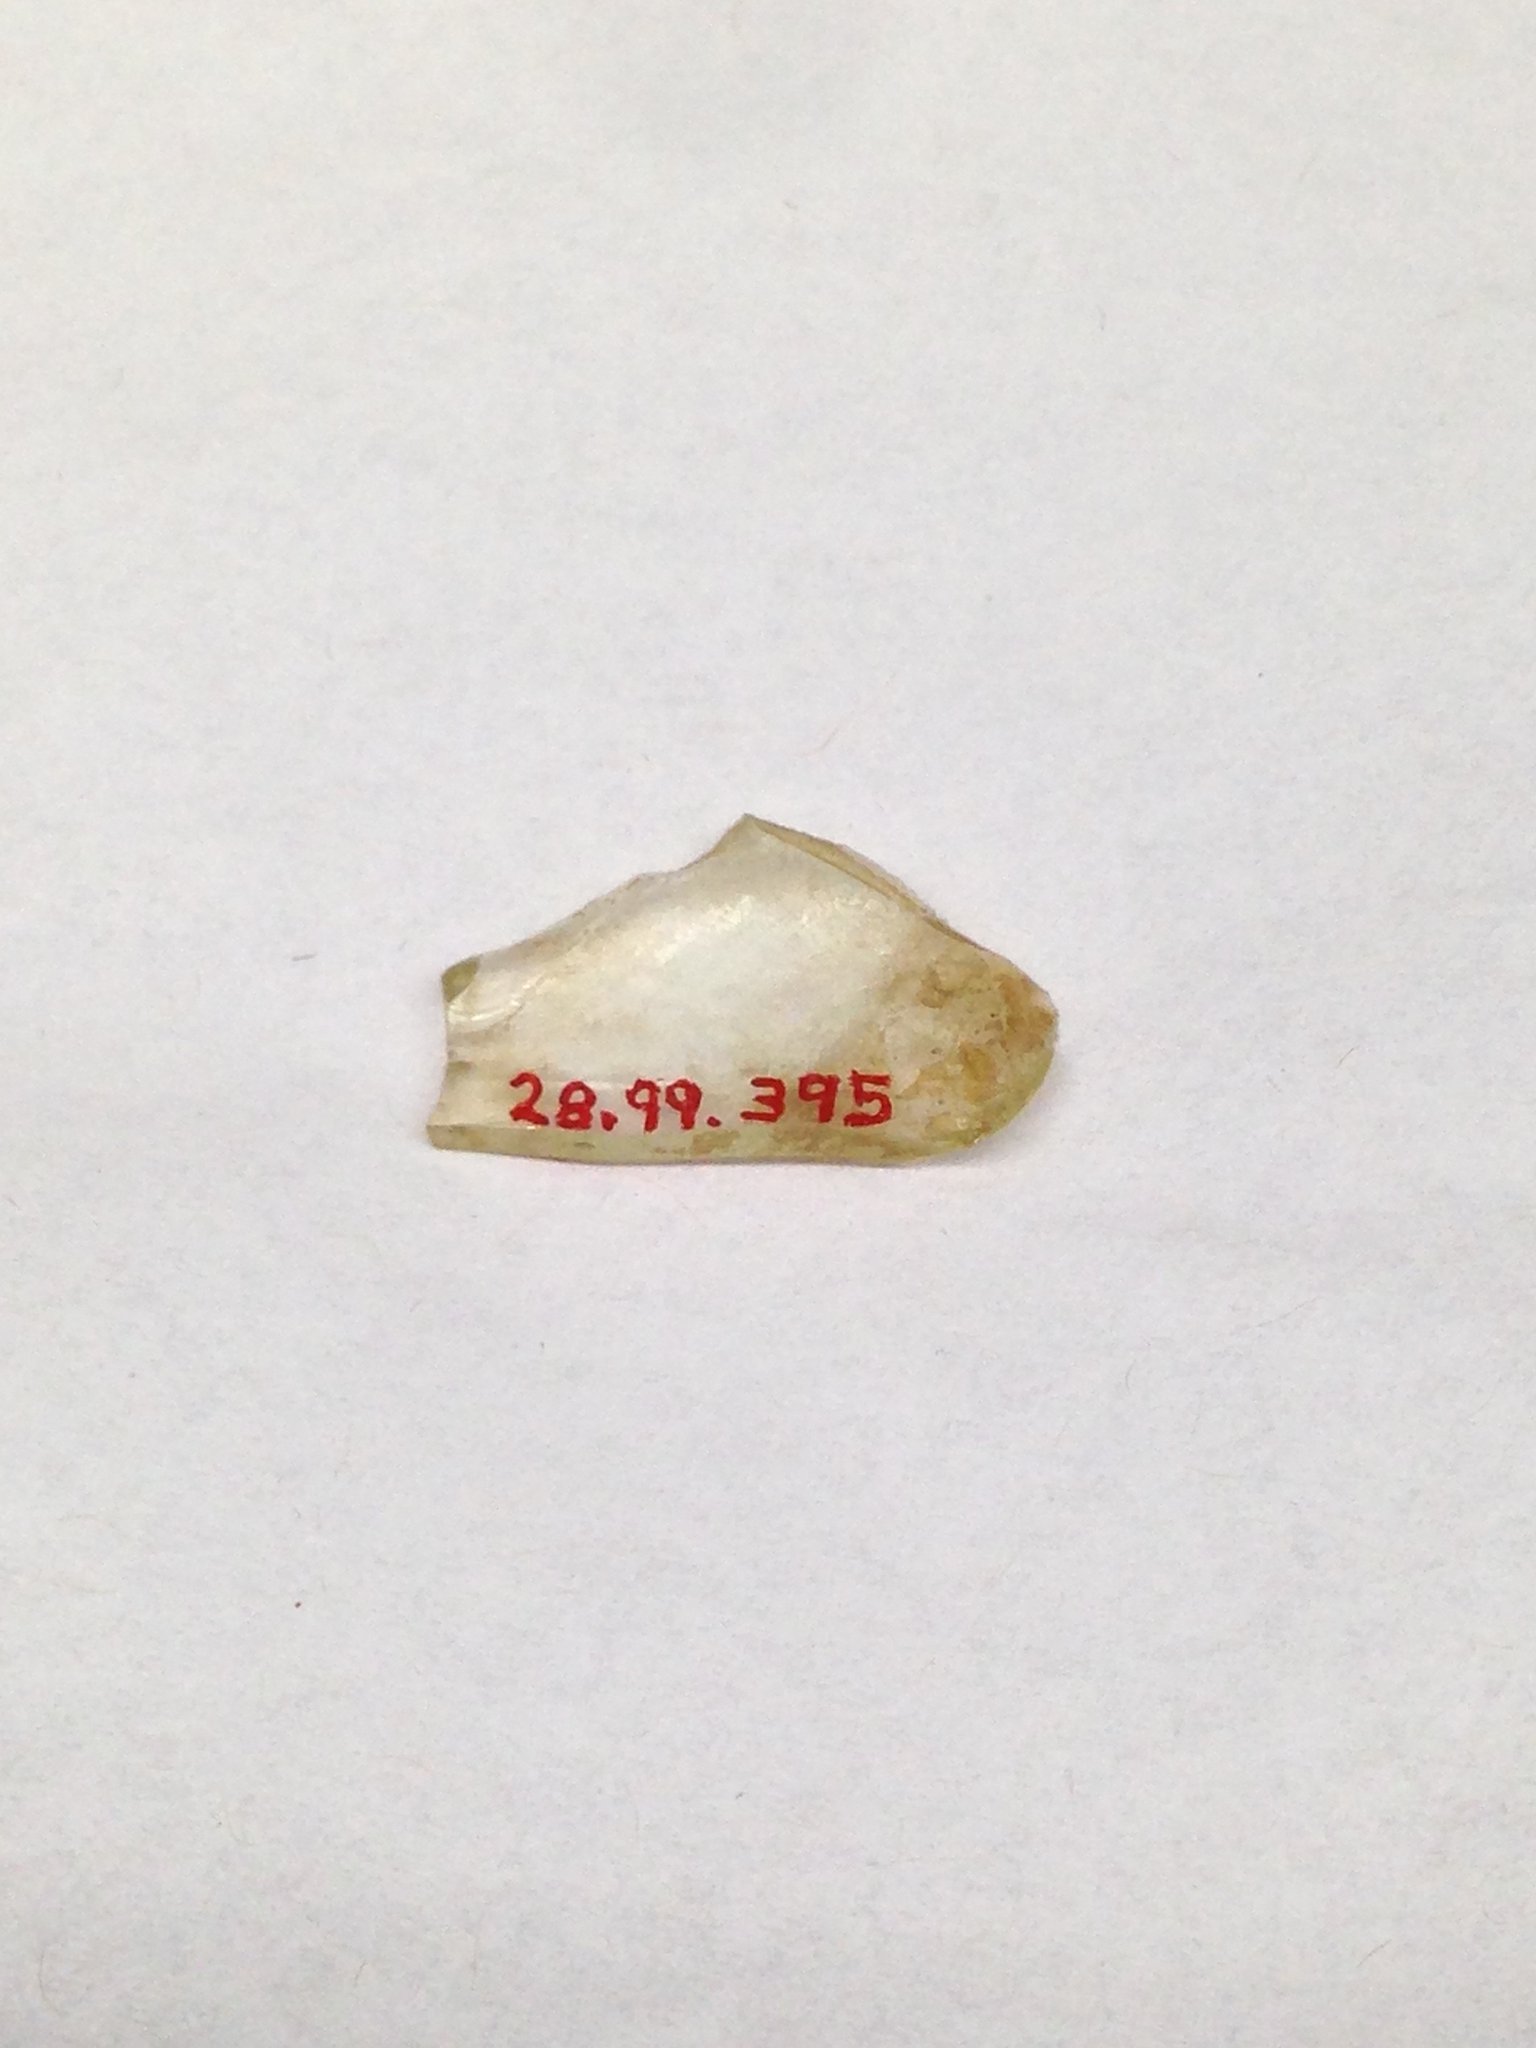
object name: fragment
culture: european or middle eastern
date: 1150-1250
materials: ceramic, glass